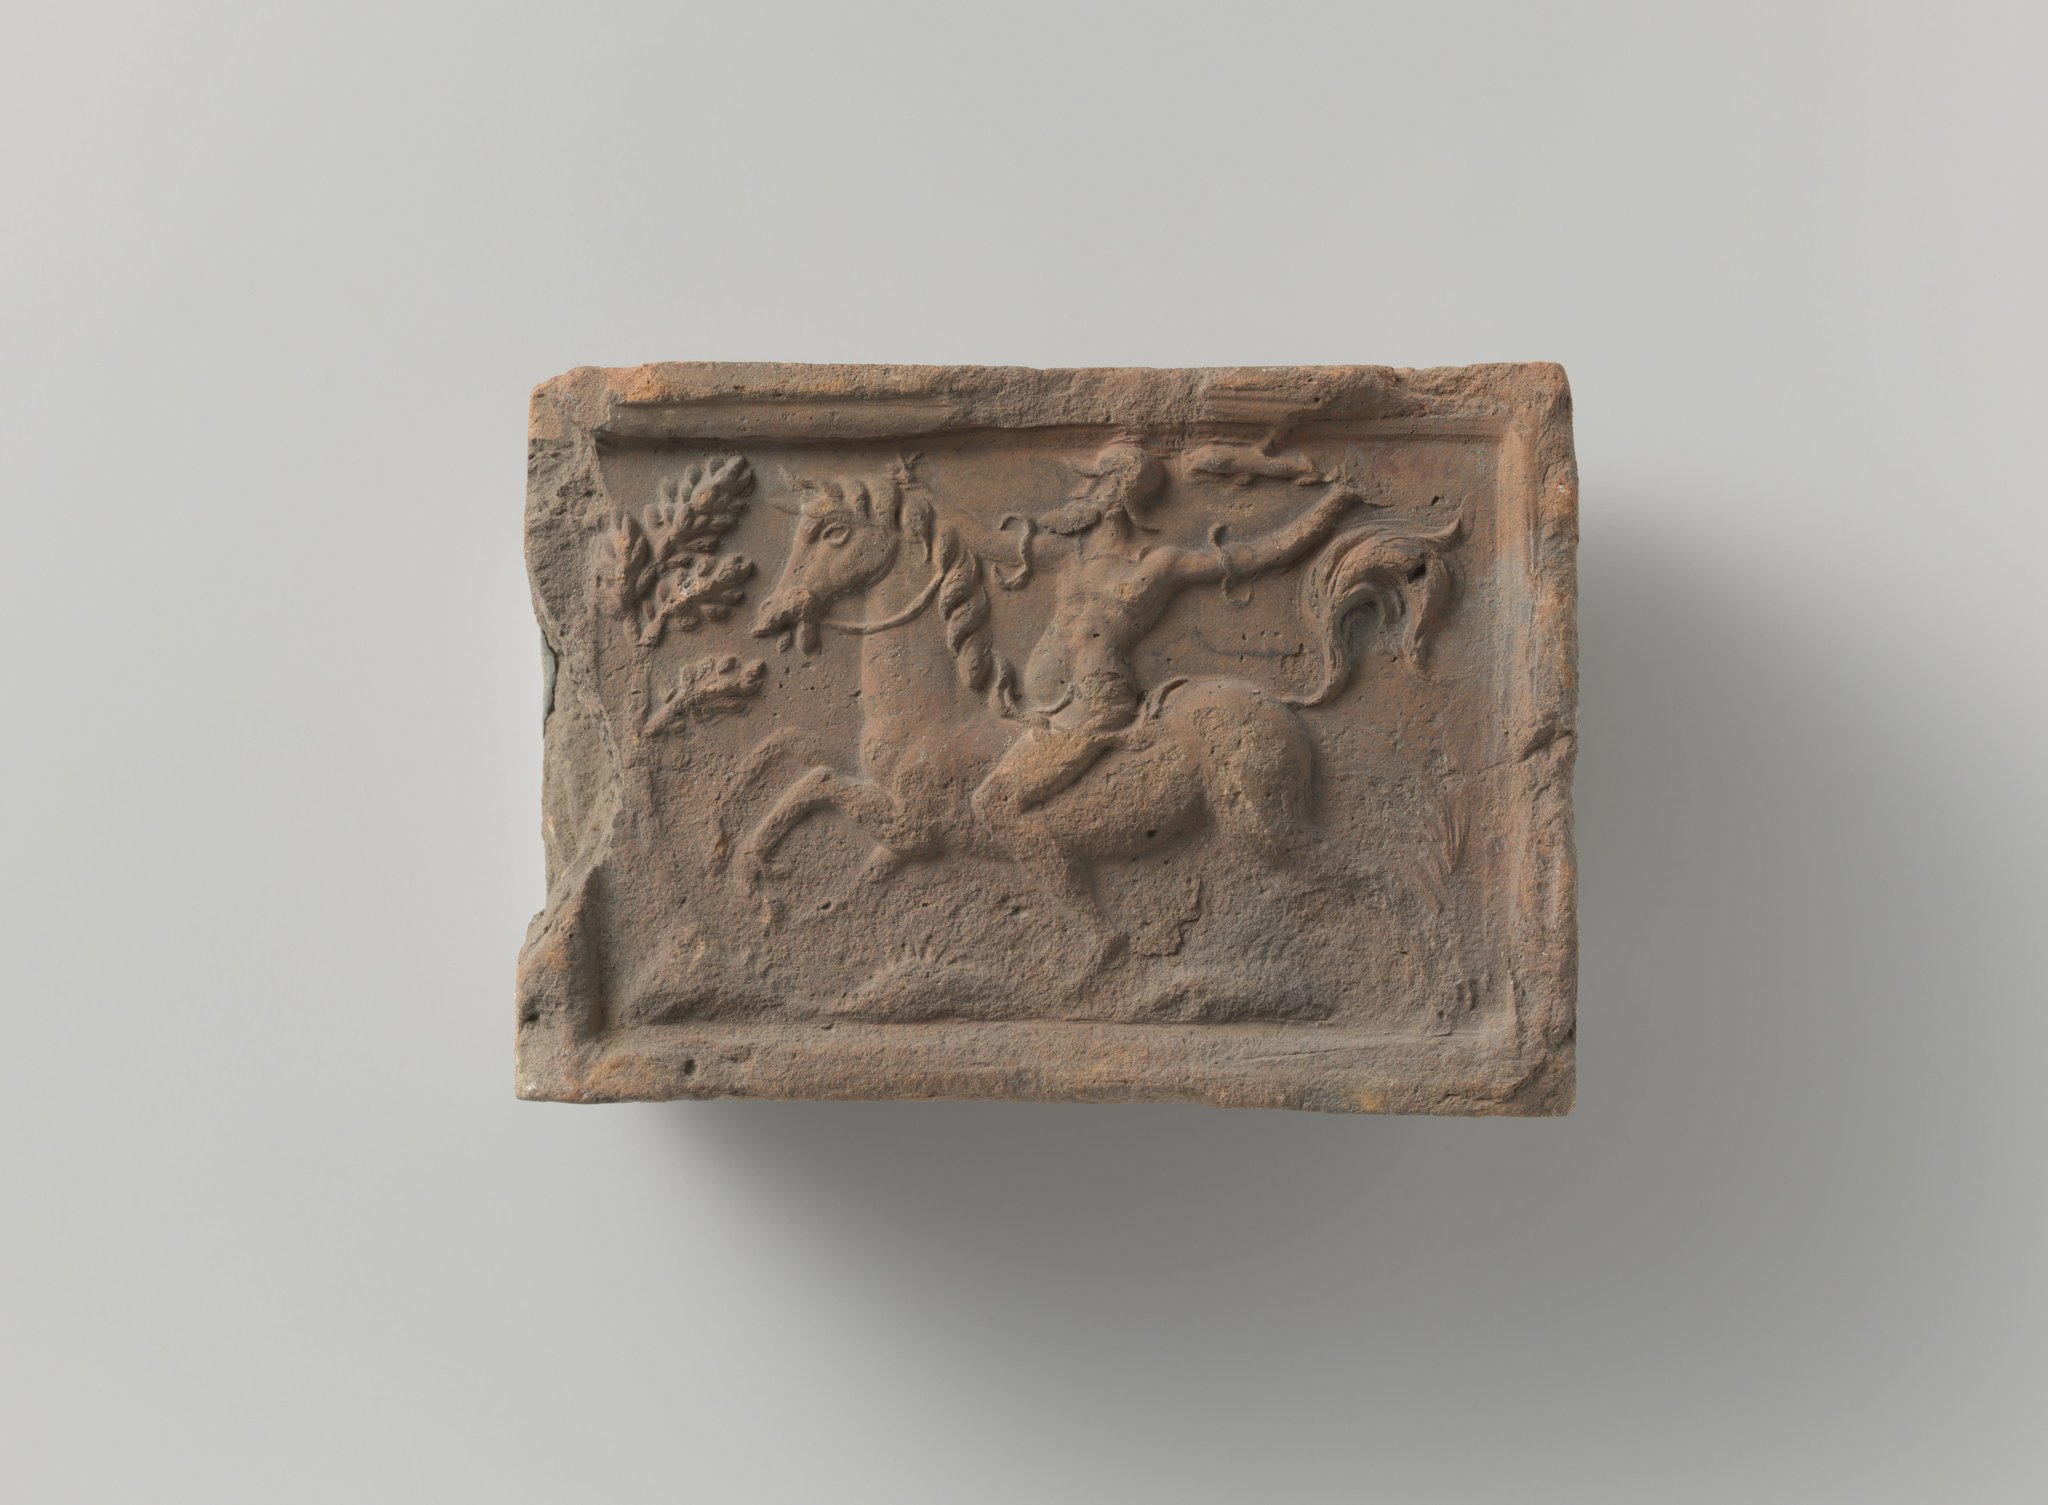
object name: hearthstone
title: Haardsteen met een voorstelling van een ruiter te paard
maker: Anonymous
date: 1499-1699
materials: earthenware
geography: southern netherlands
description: Haardsteen met een voorstelling van een ruiter te paard.